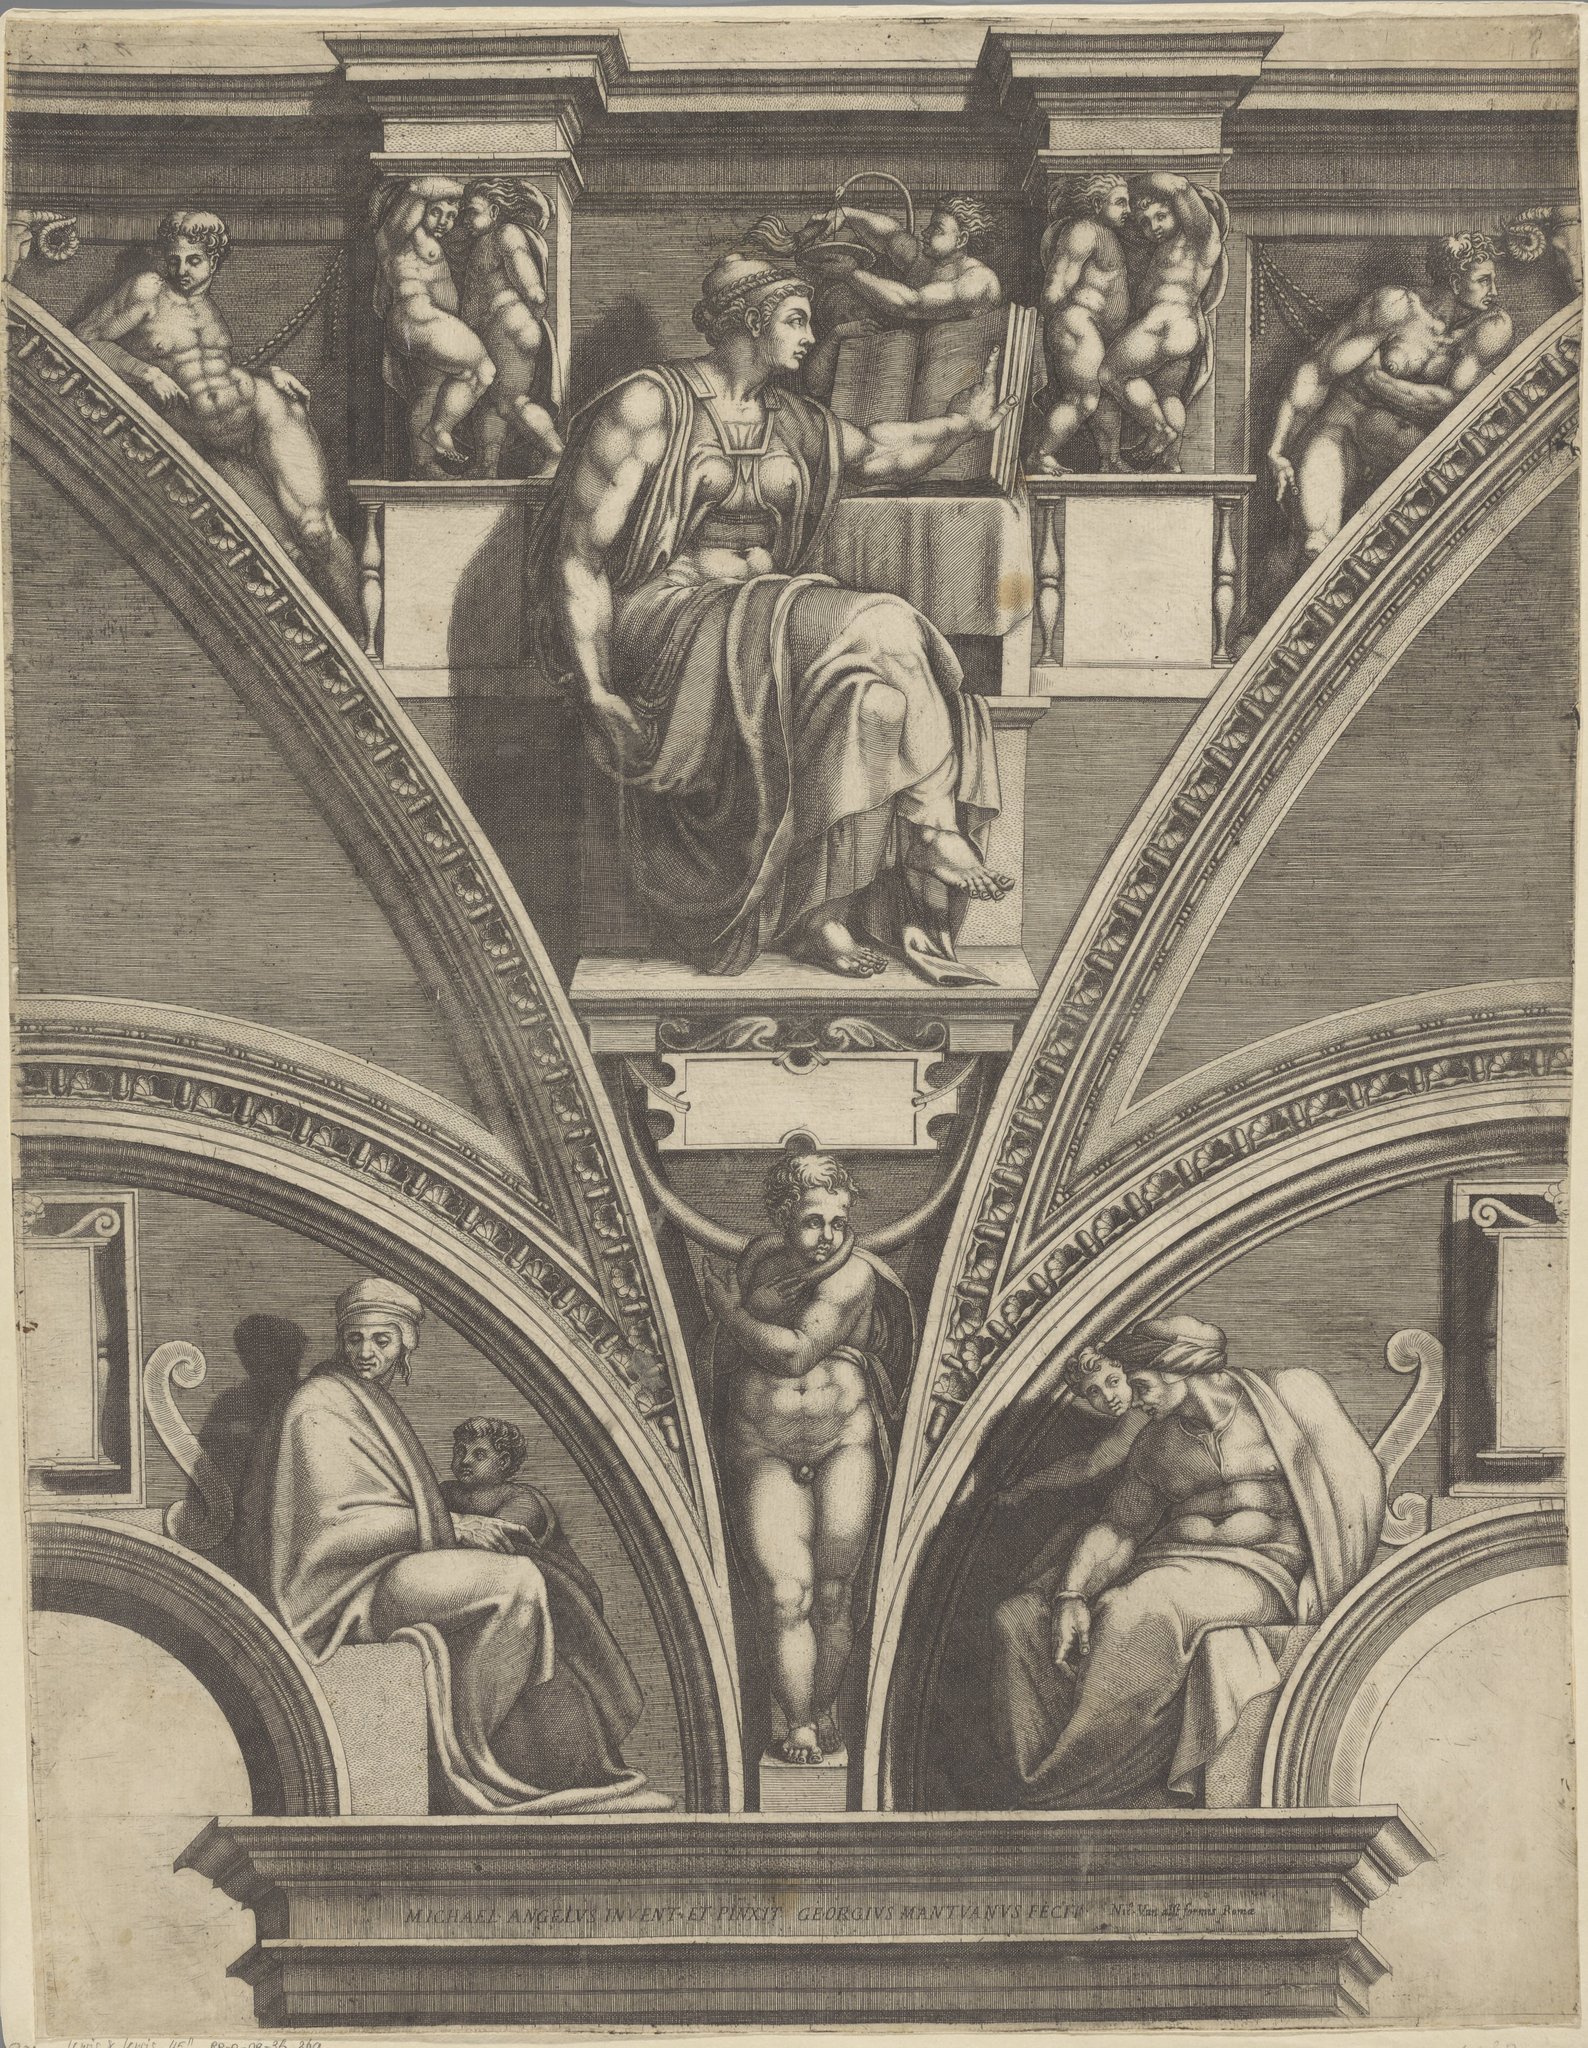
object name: print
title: Sibille van Erythrae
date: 1530-1582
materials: paper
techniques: engraving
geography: italy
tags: sibyls, erythraean sibyl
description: Prent uit een reeks van 6 prenten naar de schilderingen in de lunetten boven de ramen in de Sixtijnse Kapel door Michelangelo.